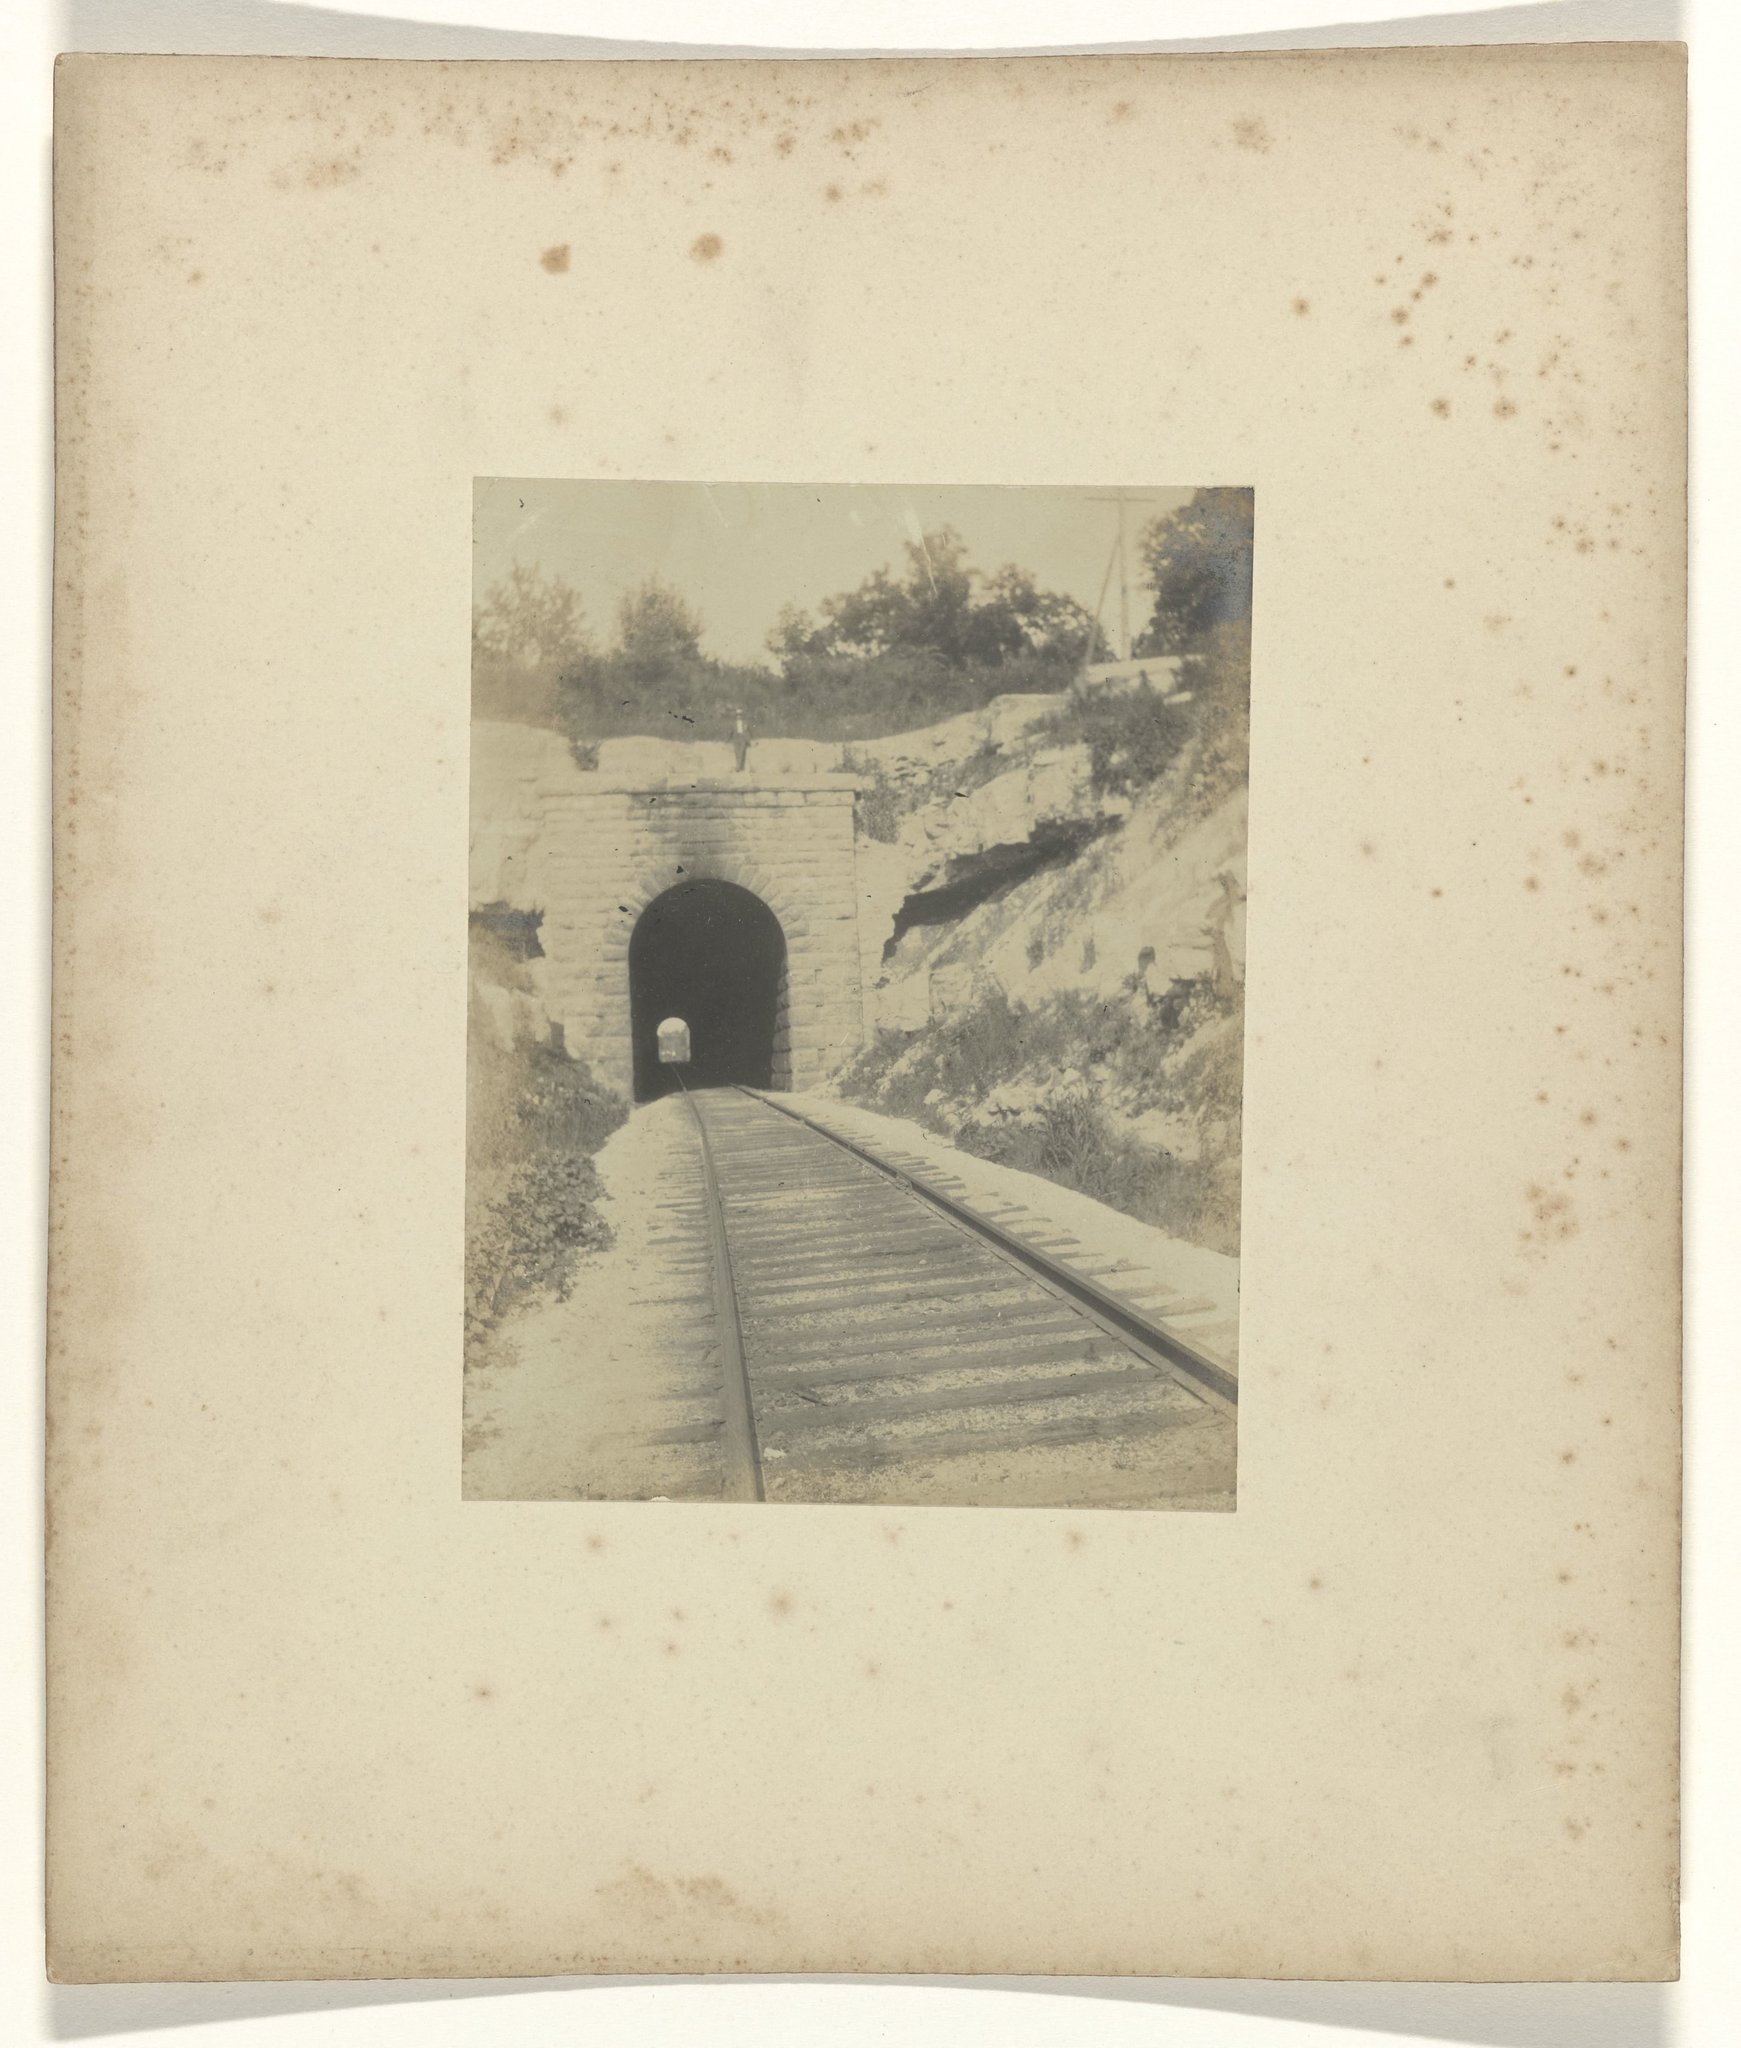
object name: photograph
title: Jan C. Schüller op een spoortunnel, Meramec Highlands tijdens de wereldtentoonstelling in St. Louis (Louisiana Purchase Exposition), 1904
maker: Anonymous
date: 1904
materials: cardboard, paper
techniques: gelatin silver print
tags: painter, print maker, draughtsman, jan schüller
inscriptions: annotation: ‘Jan C. Schüller’, annotation: ‘Tunnel bij Meramec Highlands // Ik zelf boven op den tunnelmuur // genomen door Backers’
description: Jan C. Schüller op een spoortunnel, Meramec Highlands tijdens de wereldtentoonstelling in St. Louis (Louisiana Purchase Exposition), 1904.